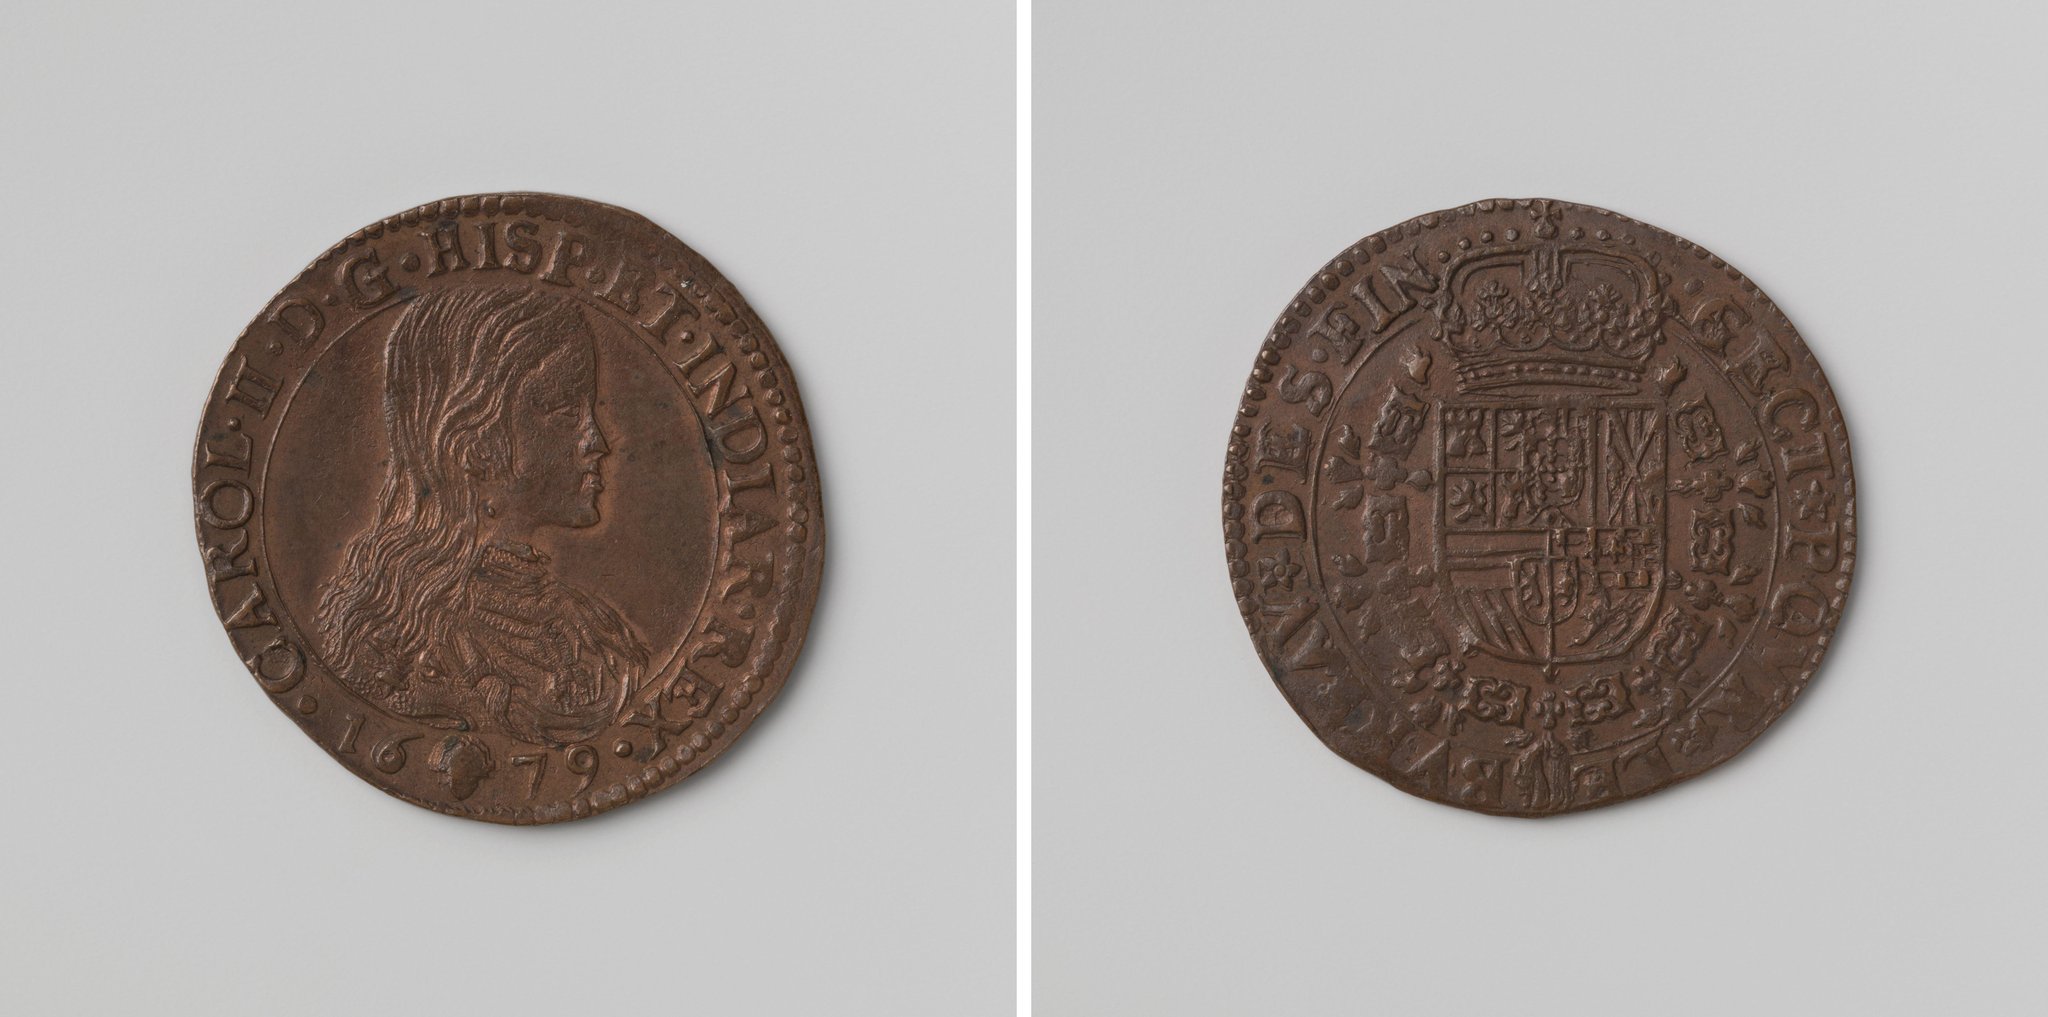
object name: jeton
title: Karel II, koning van Spanje, rekenpenning geslagen op last van de raad van Financiën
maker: Anonymous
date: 1679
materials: copper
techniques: striking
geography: brussels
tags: karel ii (koning van spanje)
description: Koperen penning. Voorzijde: borststuk man binnen omschrift. Keerzijde: gekroond wapenschild, omhangen met de orde van het Gulden Vlies binnen omschrift